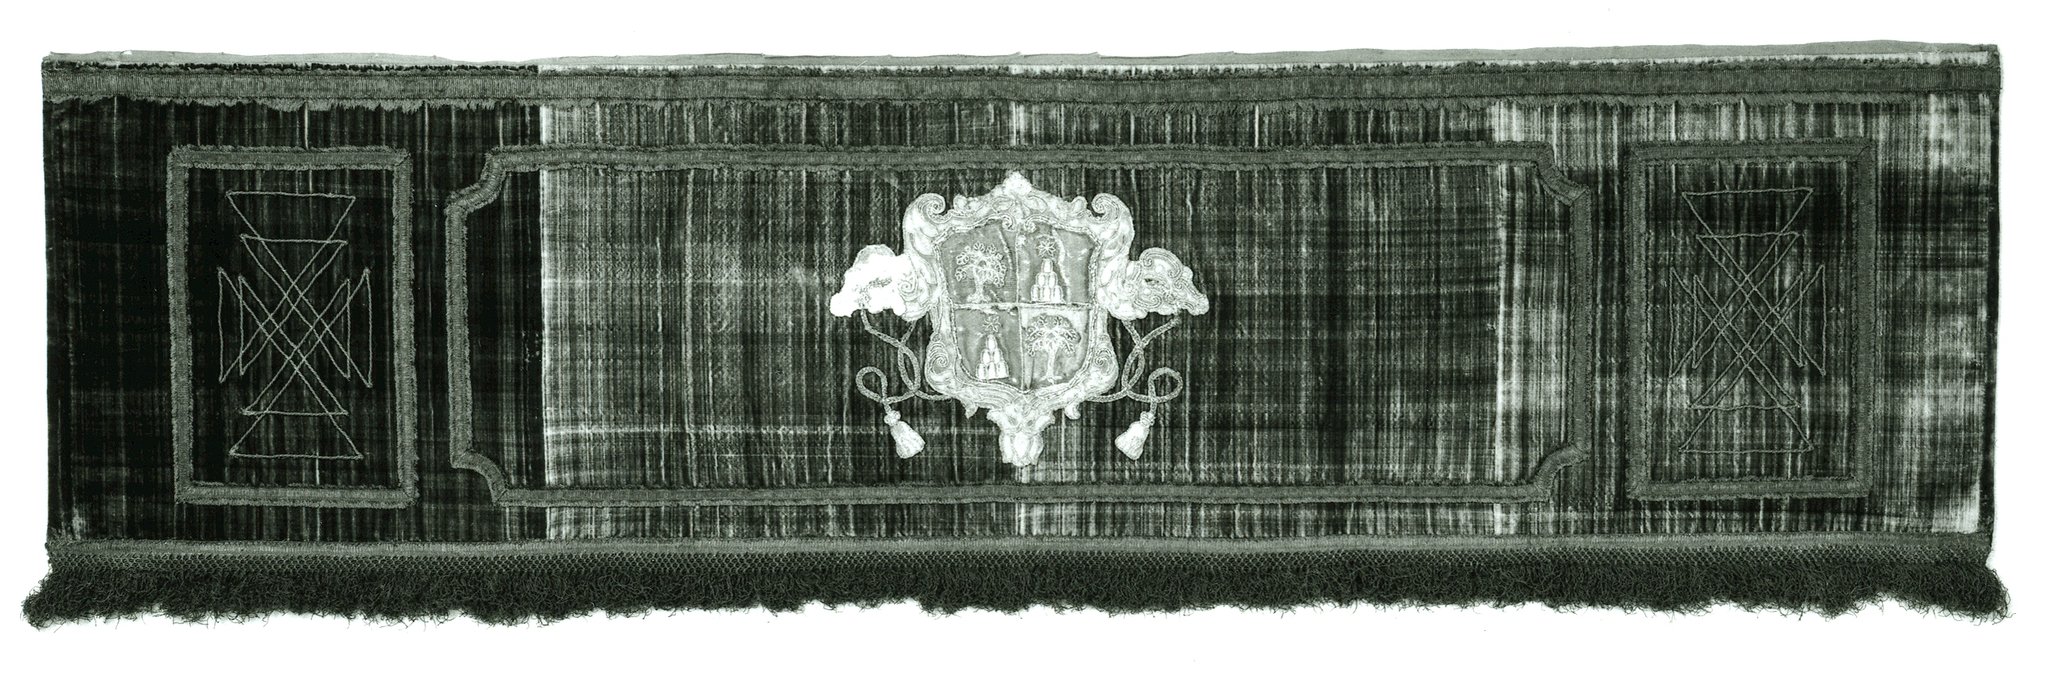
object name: valance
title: Valance with Chigi coat of arms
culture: italian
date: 1634-1666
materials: cotton, gilt, linen, silk, velvet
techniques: cutting, weave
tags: coat of arms